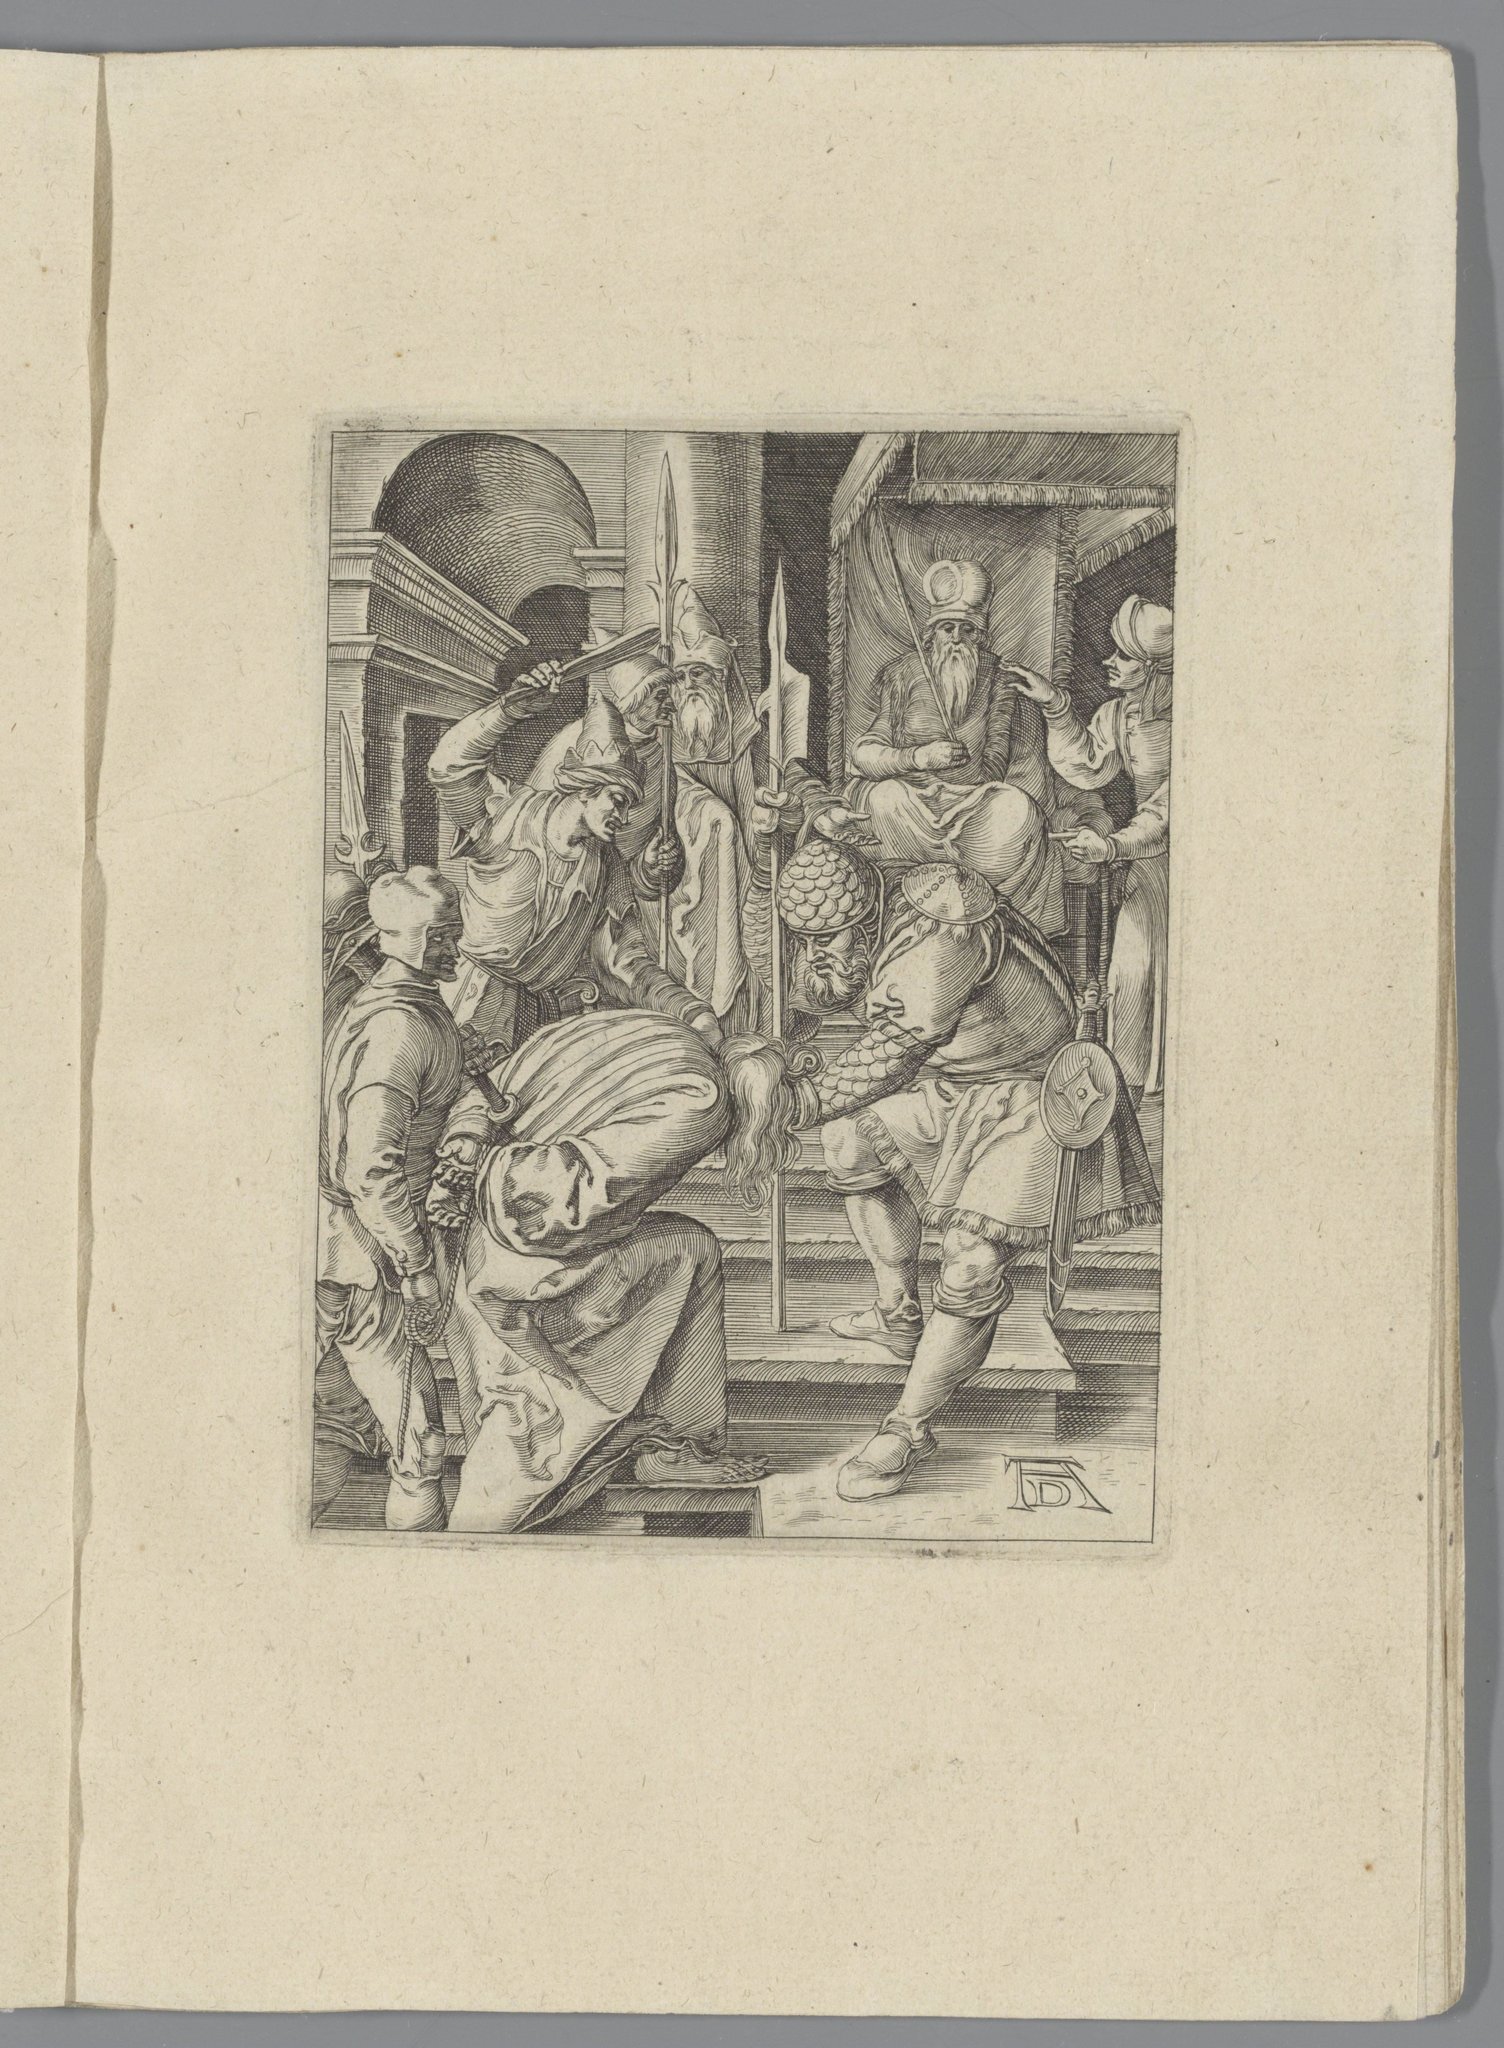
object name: print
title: Christus voor Annas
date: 1610-1620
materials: paper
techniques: engraving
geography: the hague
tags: christ before annas (hanna); maybe a soldier about to strike christ (john 18:13, 18:19-24)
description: Christus wordt door gewapende mannen voor Annas geleid. Prent maakt deel uit van een album.